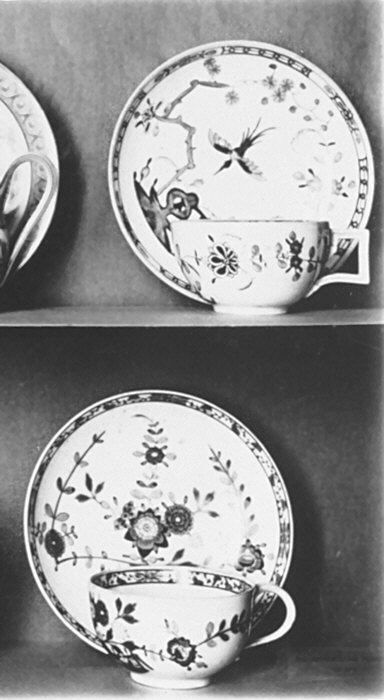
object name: cup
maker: meissen manufactory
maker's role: manufactory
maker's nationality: german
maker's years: 1710-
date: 1701-1900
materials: hard paste porcelain